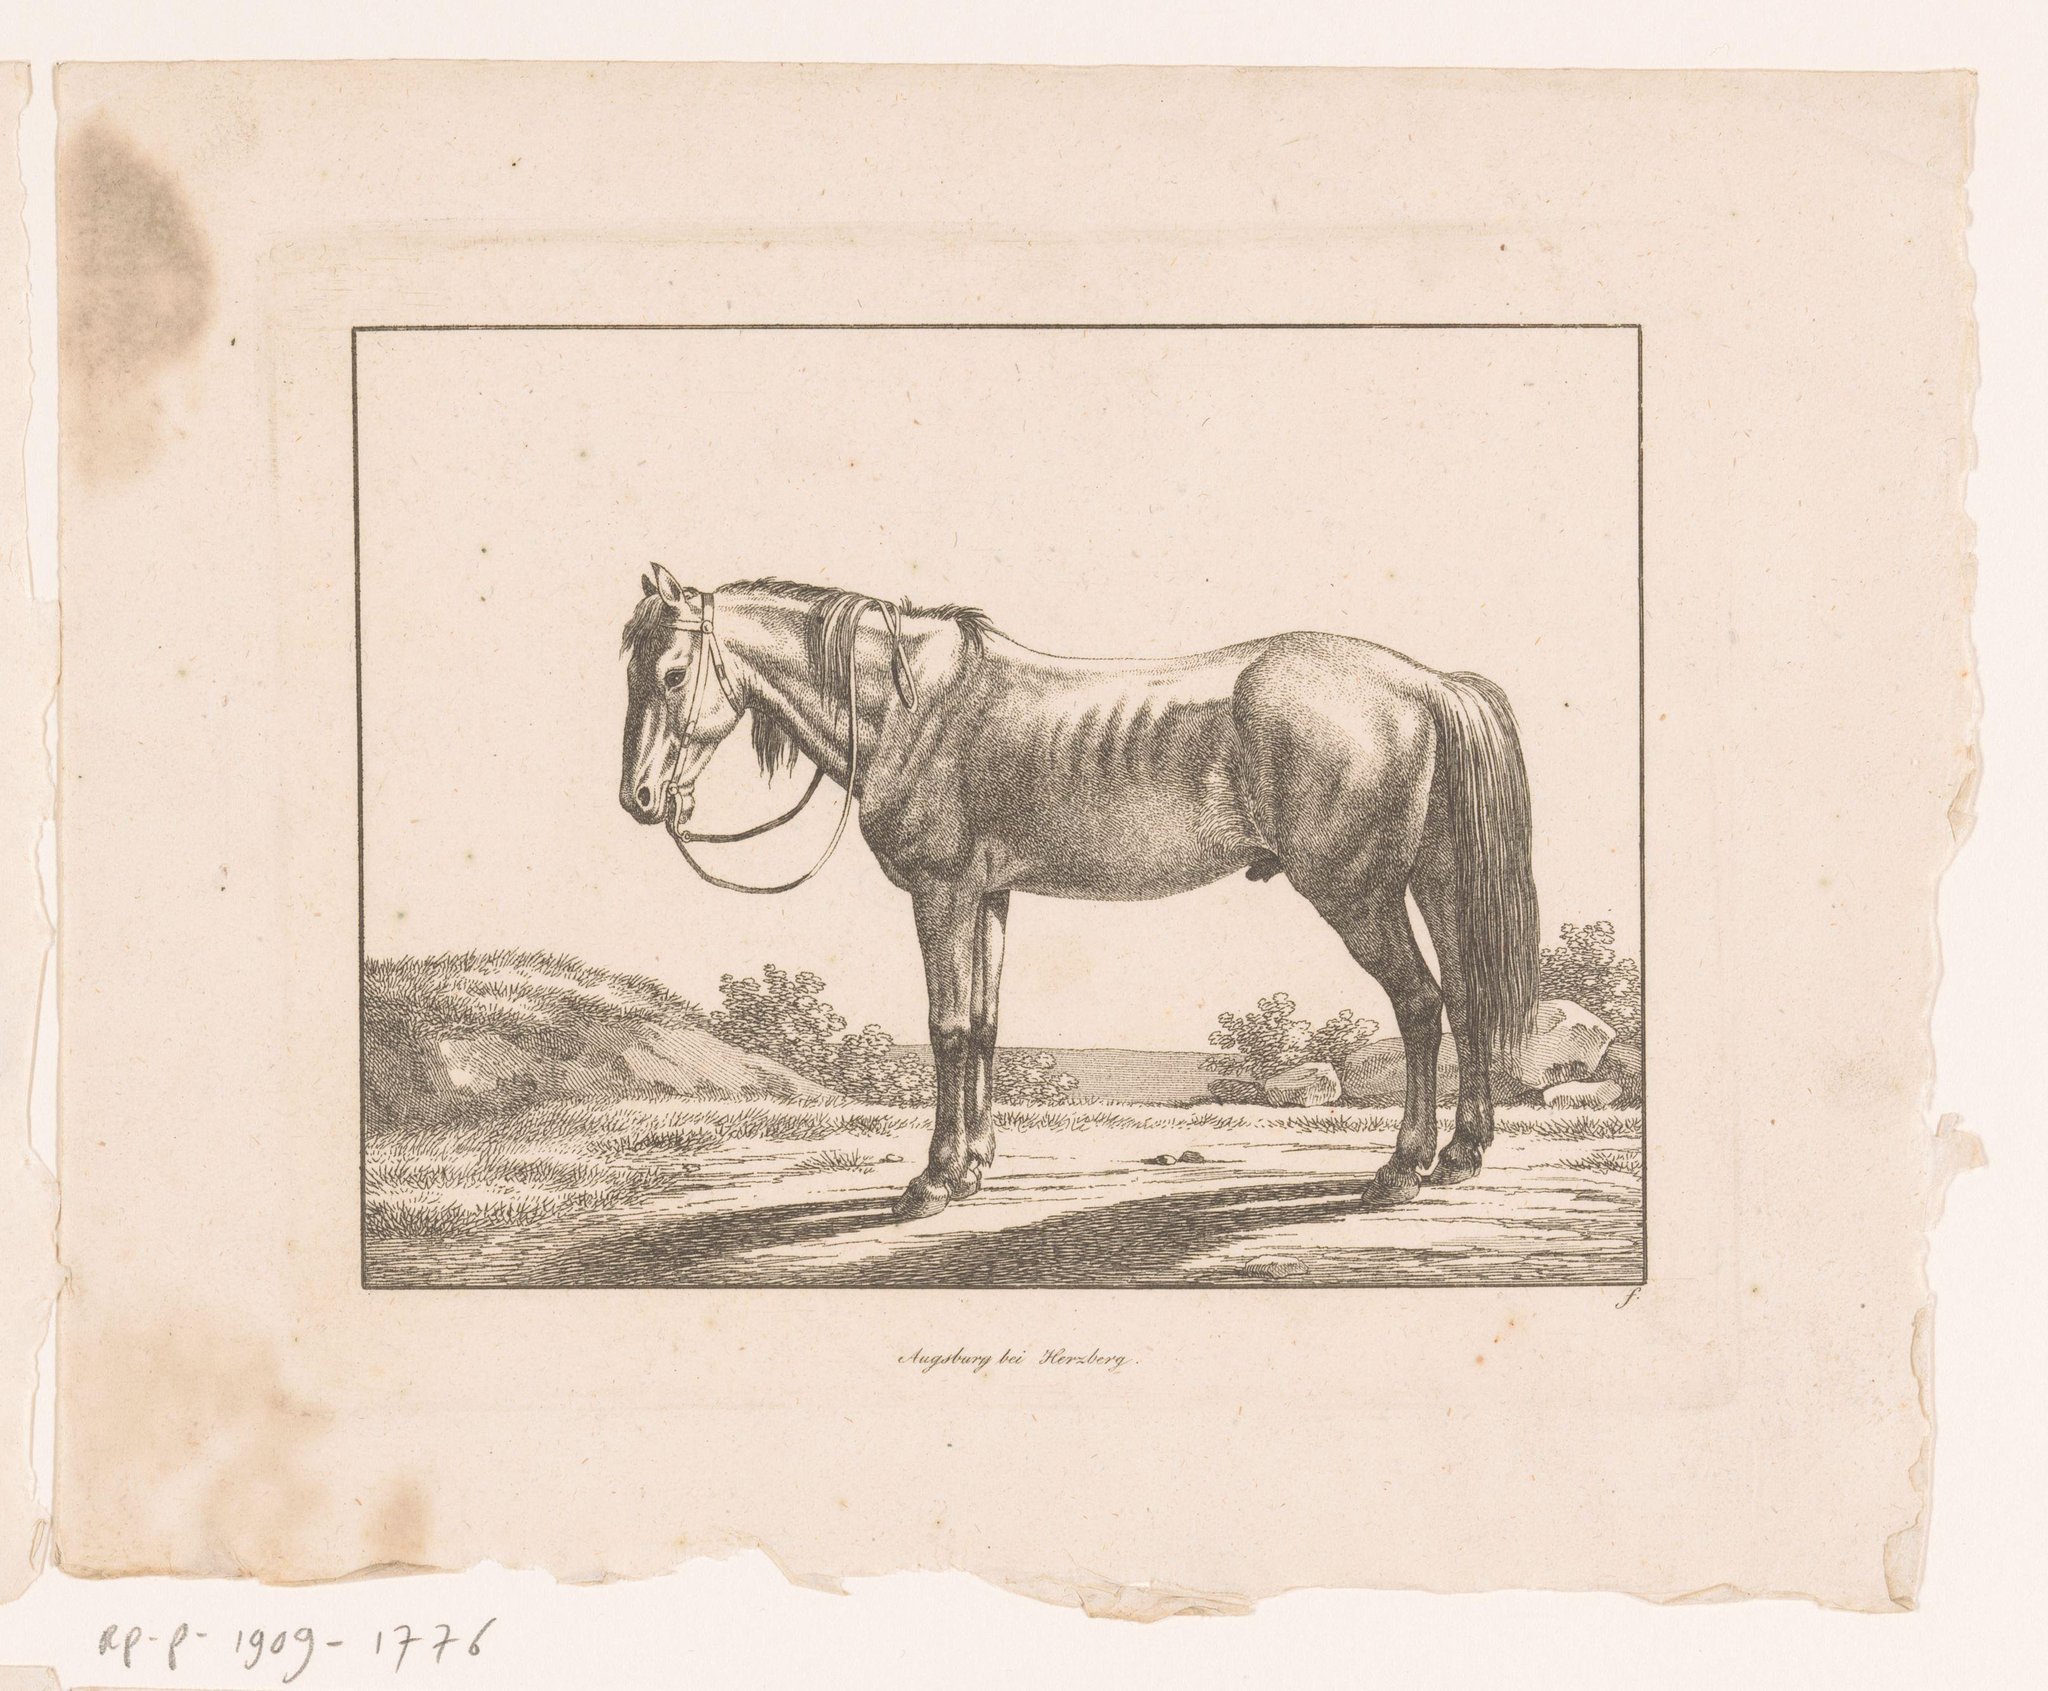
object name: print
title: Paard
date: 1750-1849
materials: paper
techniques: etching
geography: augsburg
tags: horse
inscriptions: collector's mark: Lugt 2228